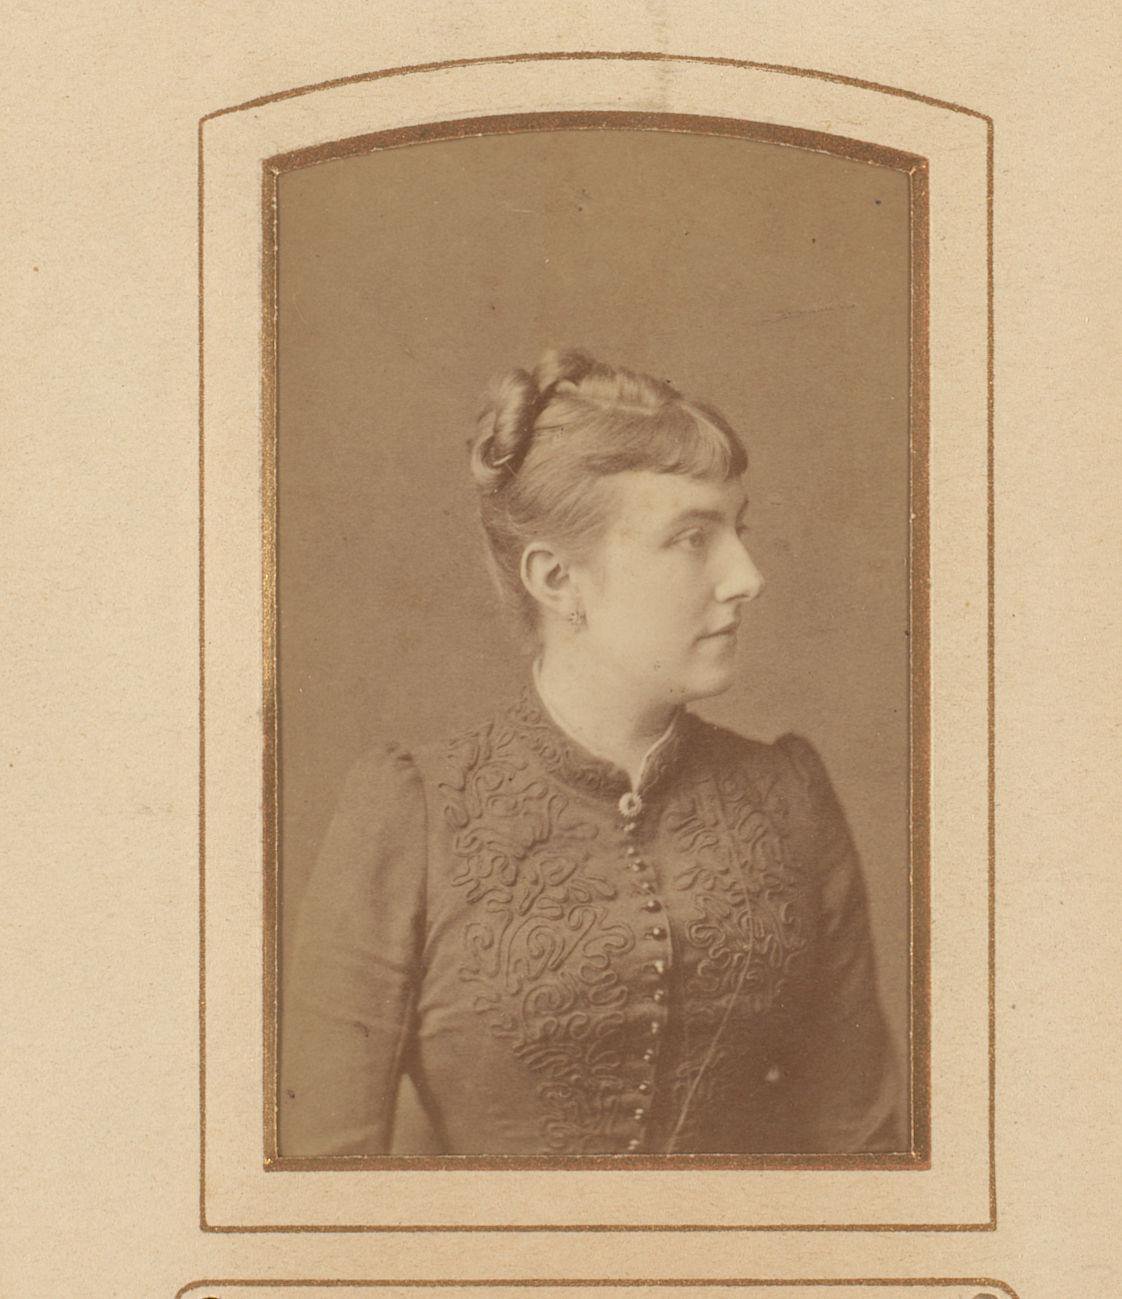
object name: album leaf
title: Portret van een vrouw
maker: Anonymous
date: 1870-1900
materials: cardboard, photographic support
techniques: albumen print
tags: historical persons - bb - woman